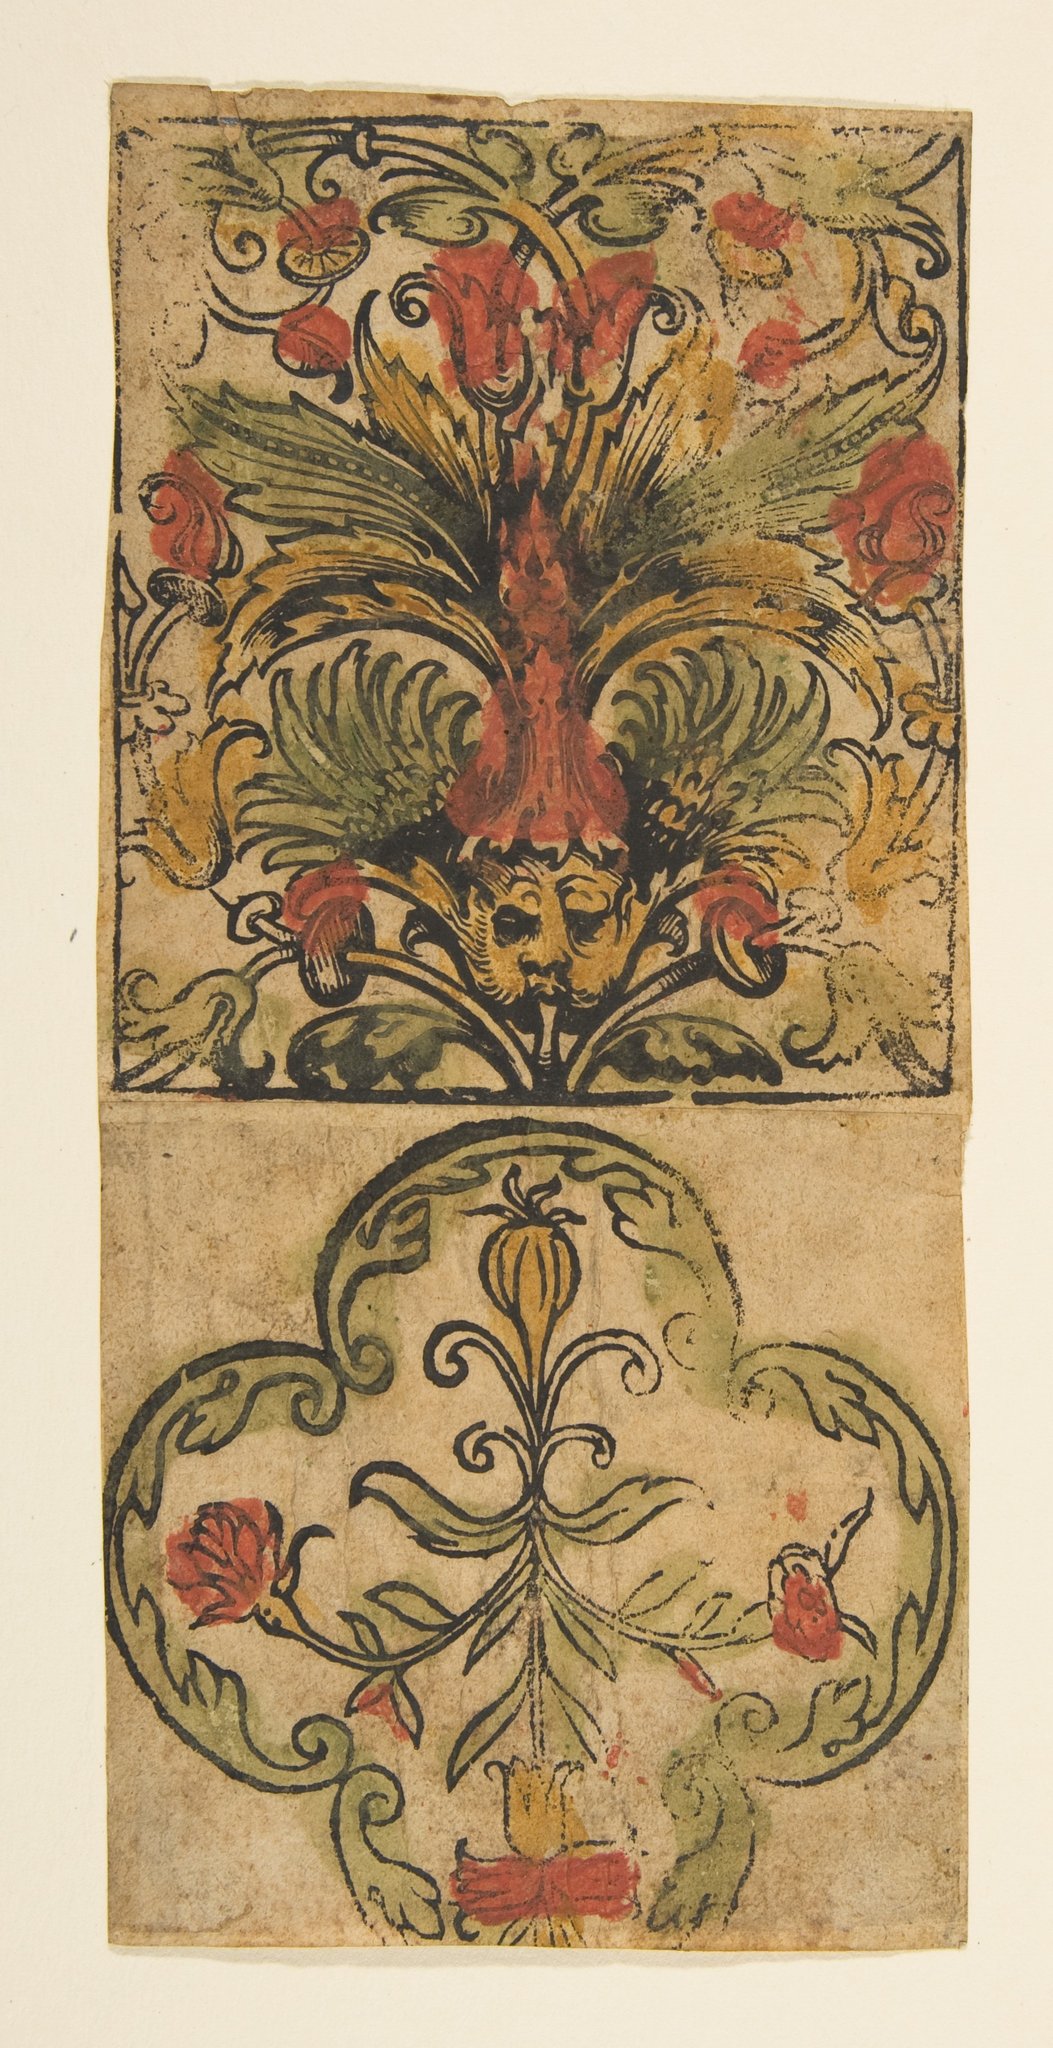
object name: collection ornament architecture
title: Panel of ornament (Schr. 2006m)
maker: anonymous, german, 15th century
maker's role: artist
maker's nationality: german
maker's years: 1400-1500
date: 1401-1500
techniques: hand coloring, woodcut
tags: ornament,flowers